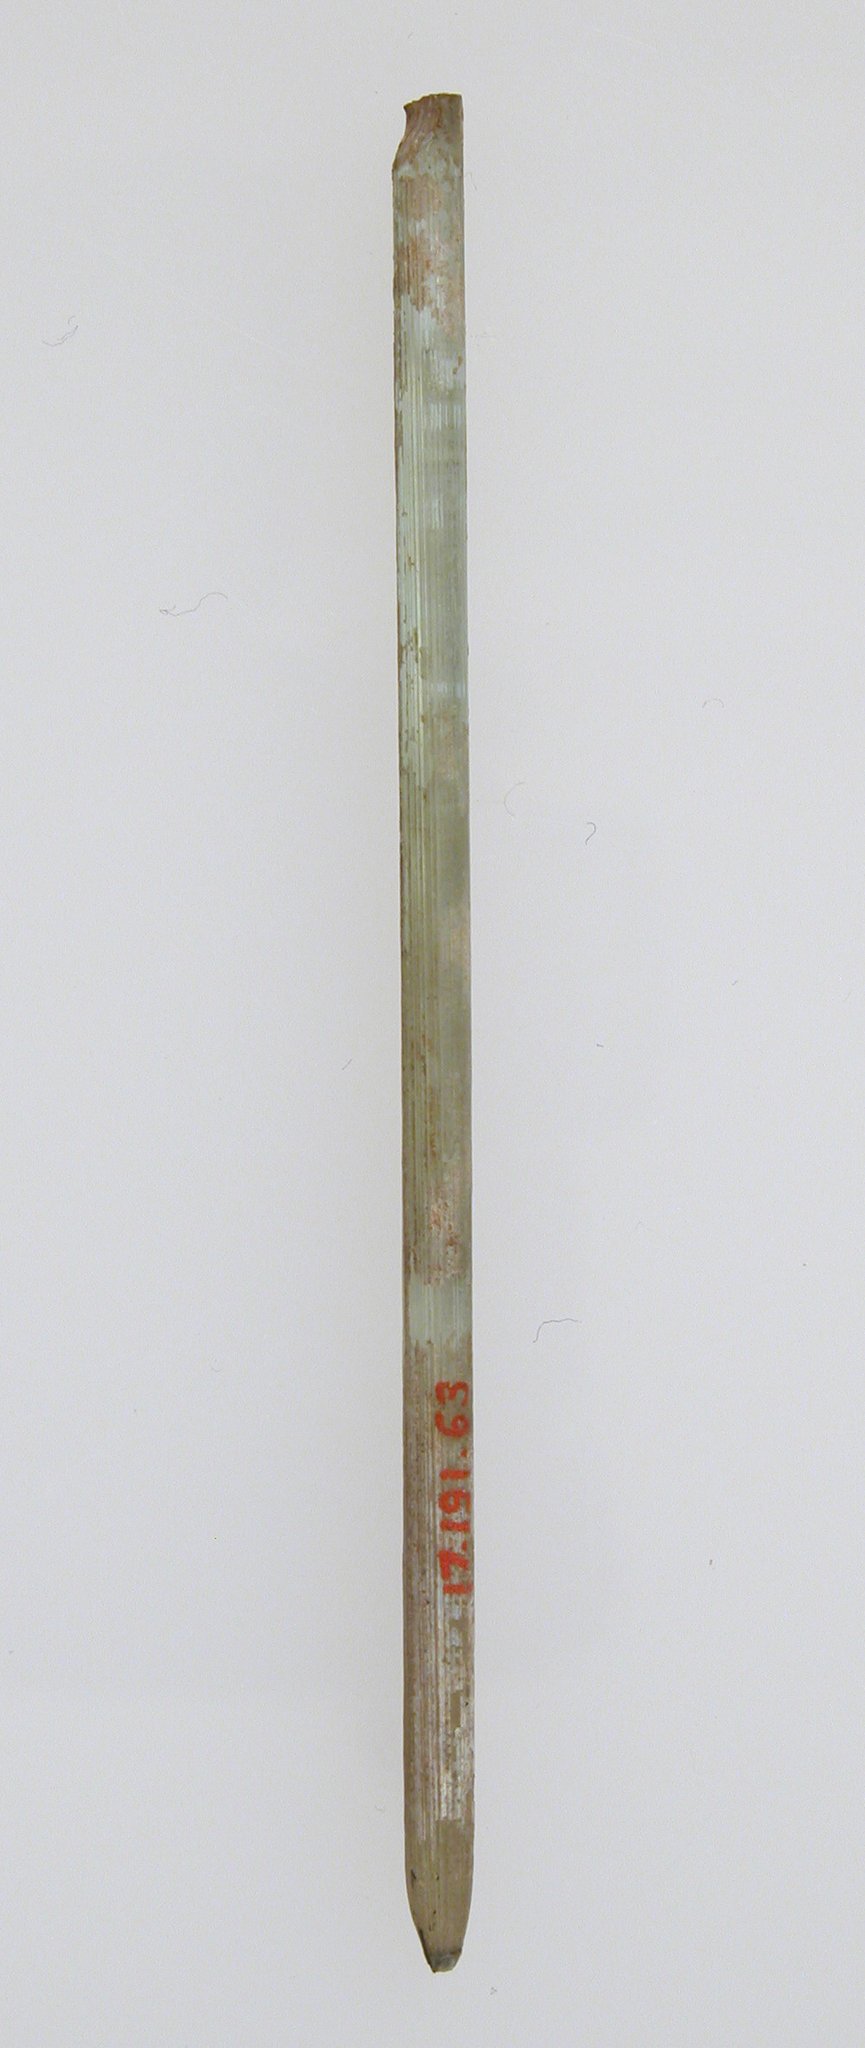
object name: hairpin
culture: roman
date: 1-400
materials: glass